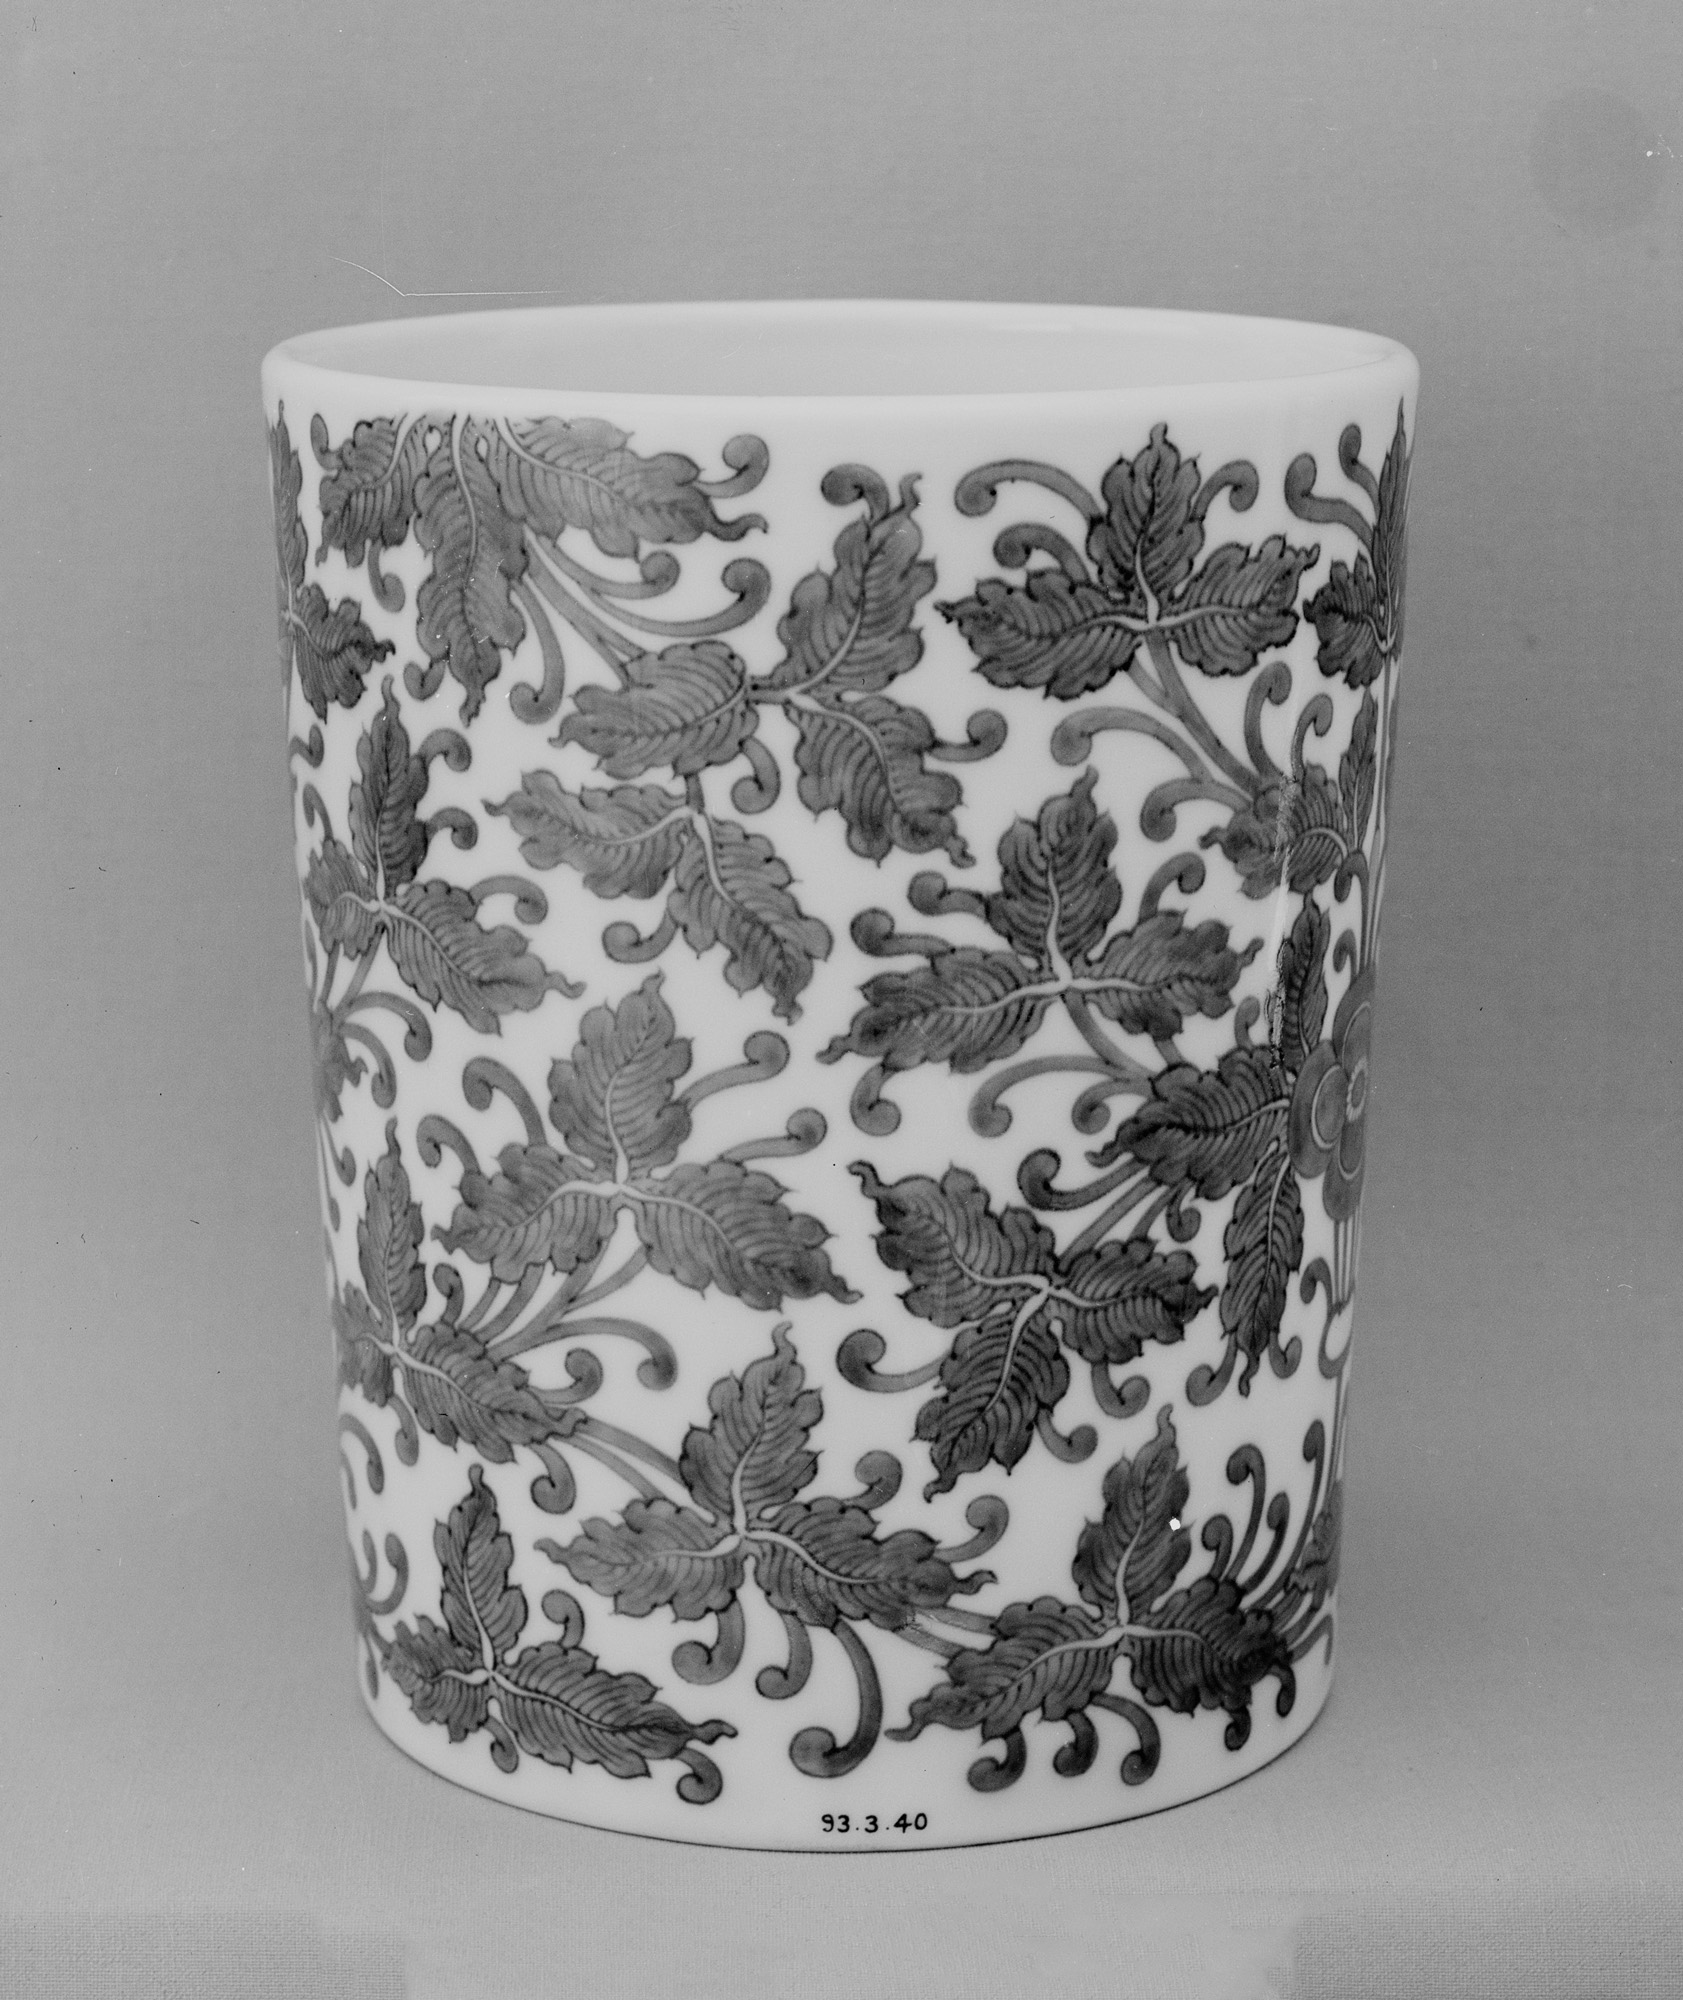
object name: water pot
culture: japanese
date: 1820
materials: glaze, porcelain